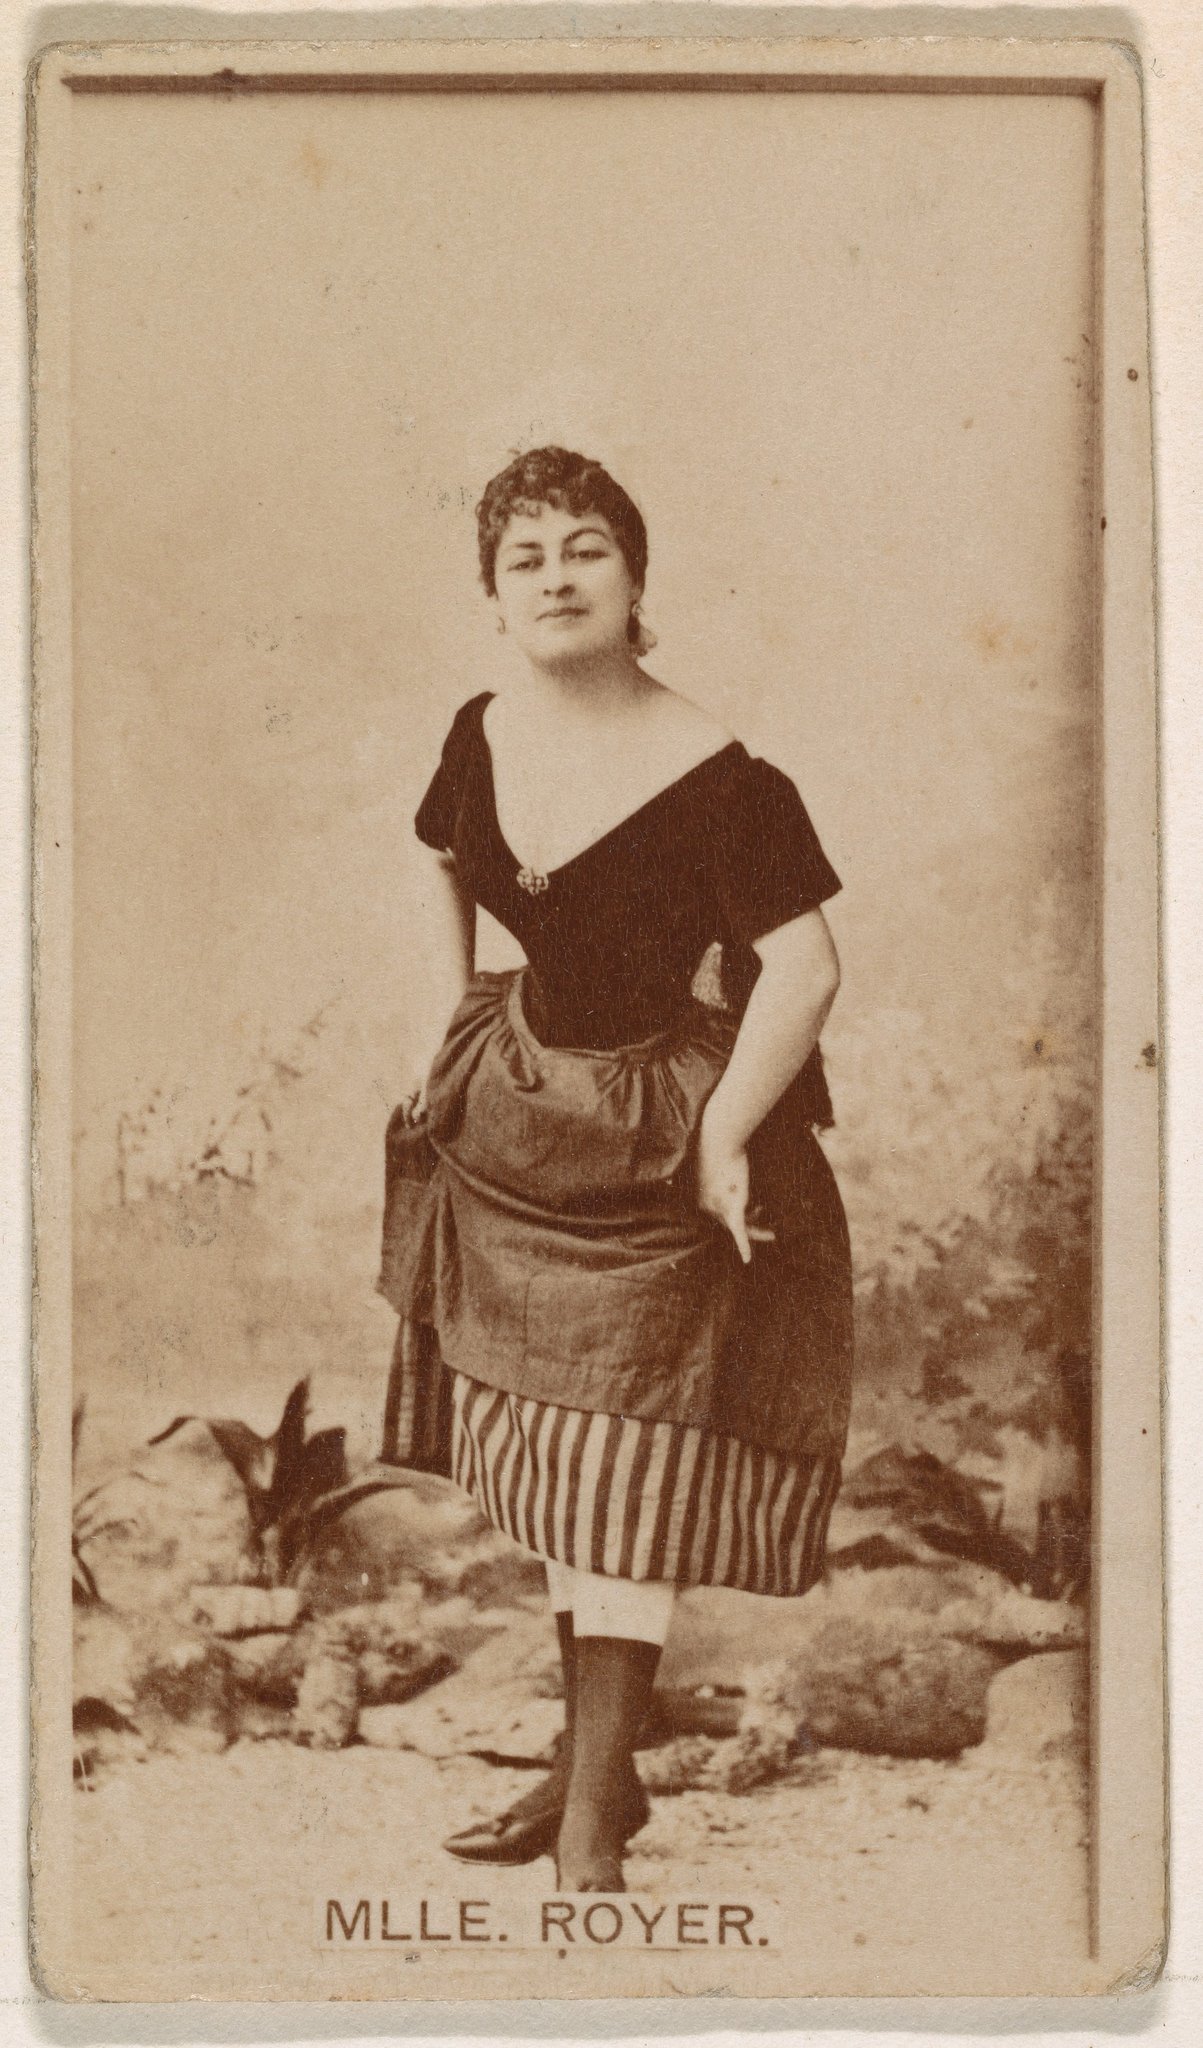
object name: photograph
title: Mlle. Royer, from the Actresses series (N245) issued by Kinney Brothers to promote Sweet Caporal Cigarettes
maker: kinney brothers tobacco company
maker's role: publisher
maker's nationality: american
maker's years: 1869-2011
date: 1890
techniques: albumen silver print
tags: portraits,women,actresses